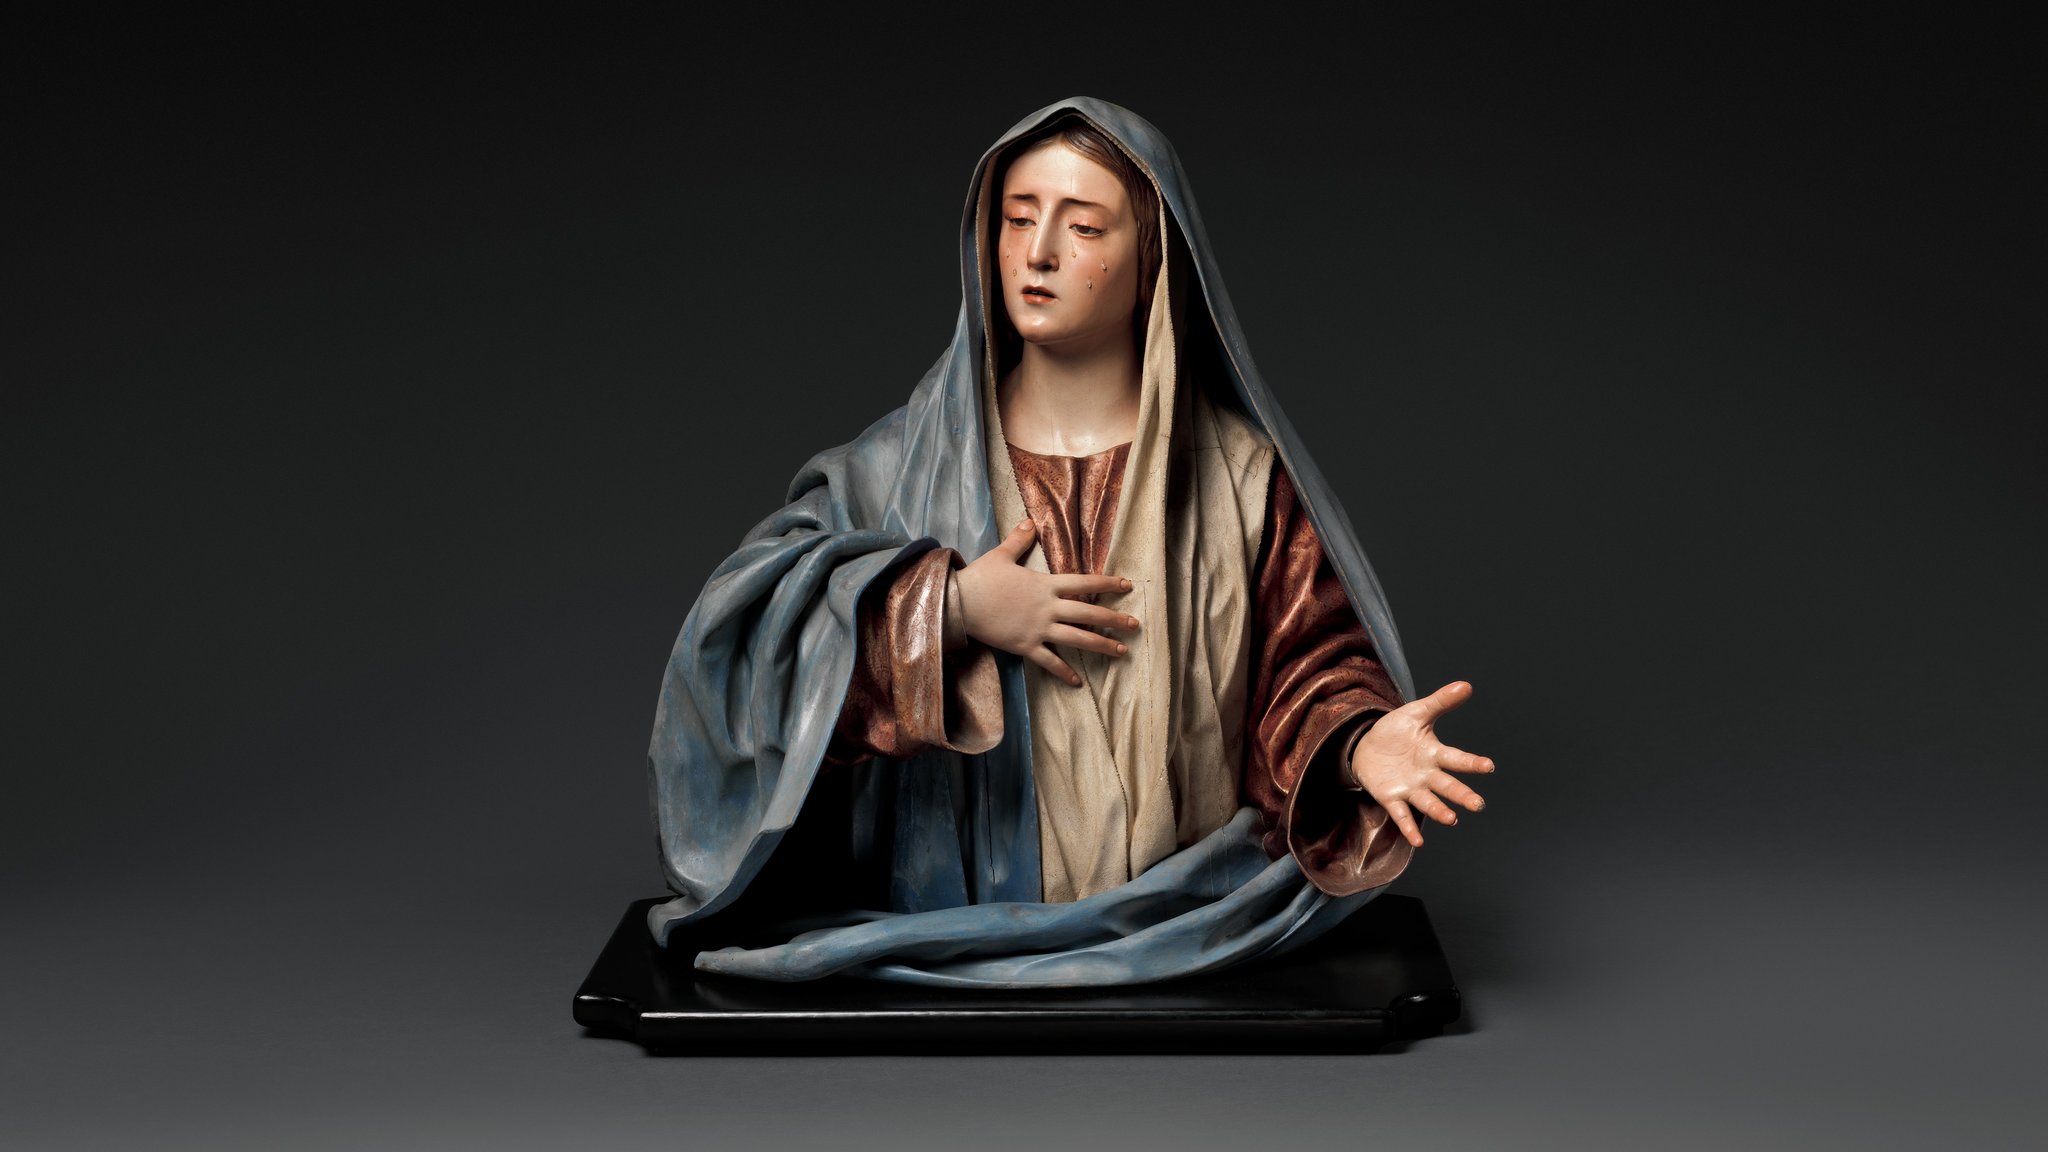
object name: half length bust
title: Mater Dolorosa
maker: pedro de mena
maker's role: artist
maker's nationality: spanish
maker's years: 1628-1688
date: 1674-1685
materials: gilt, wood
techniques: polychrome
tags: sadness,virgin mary